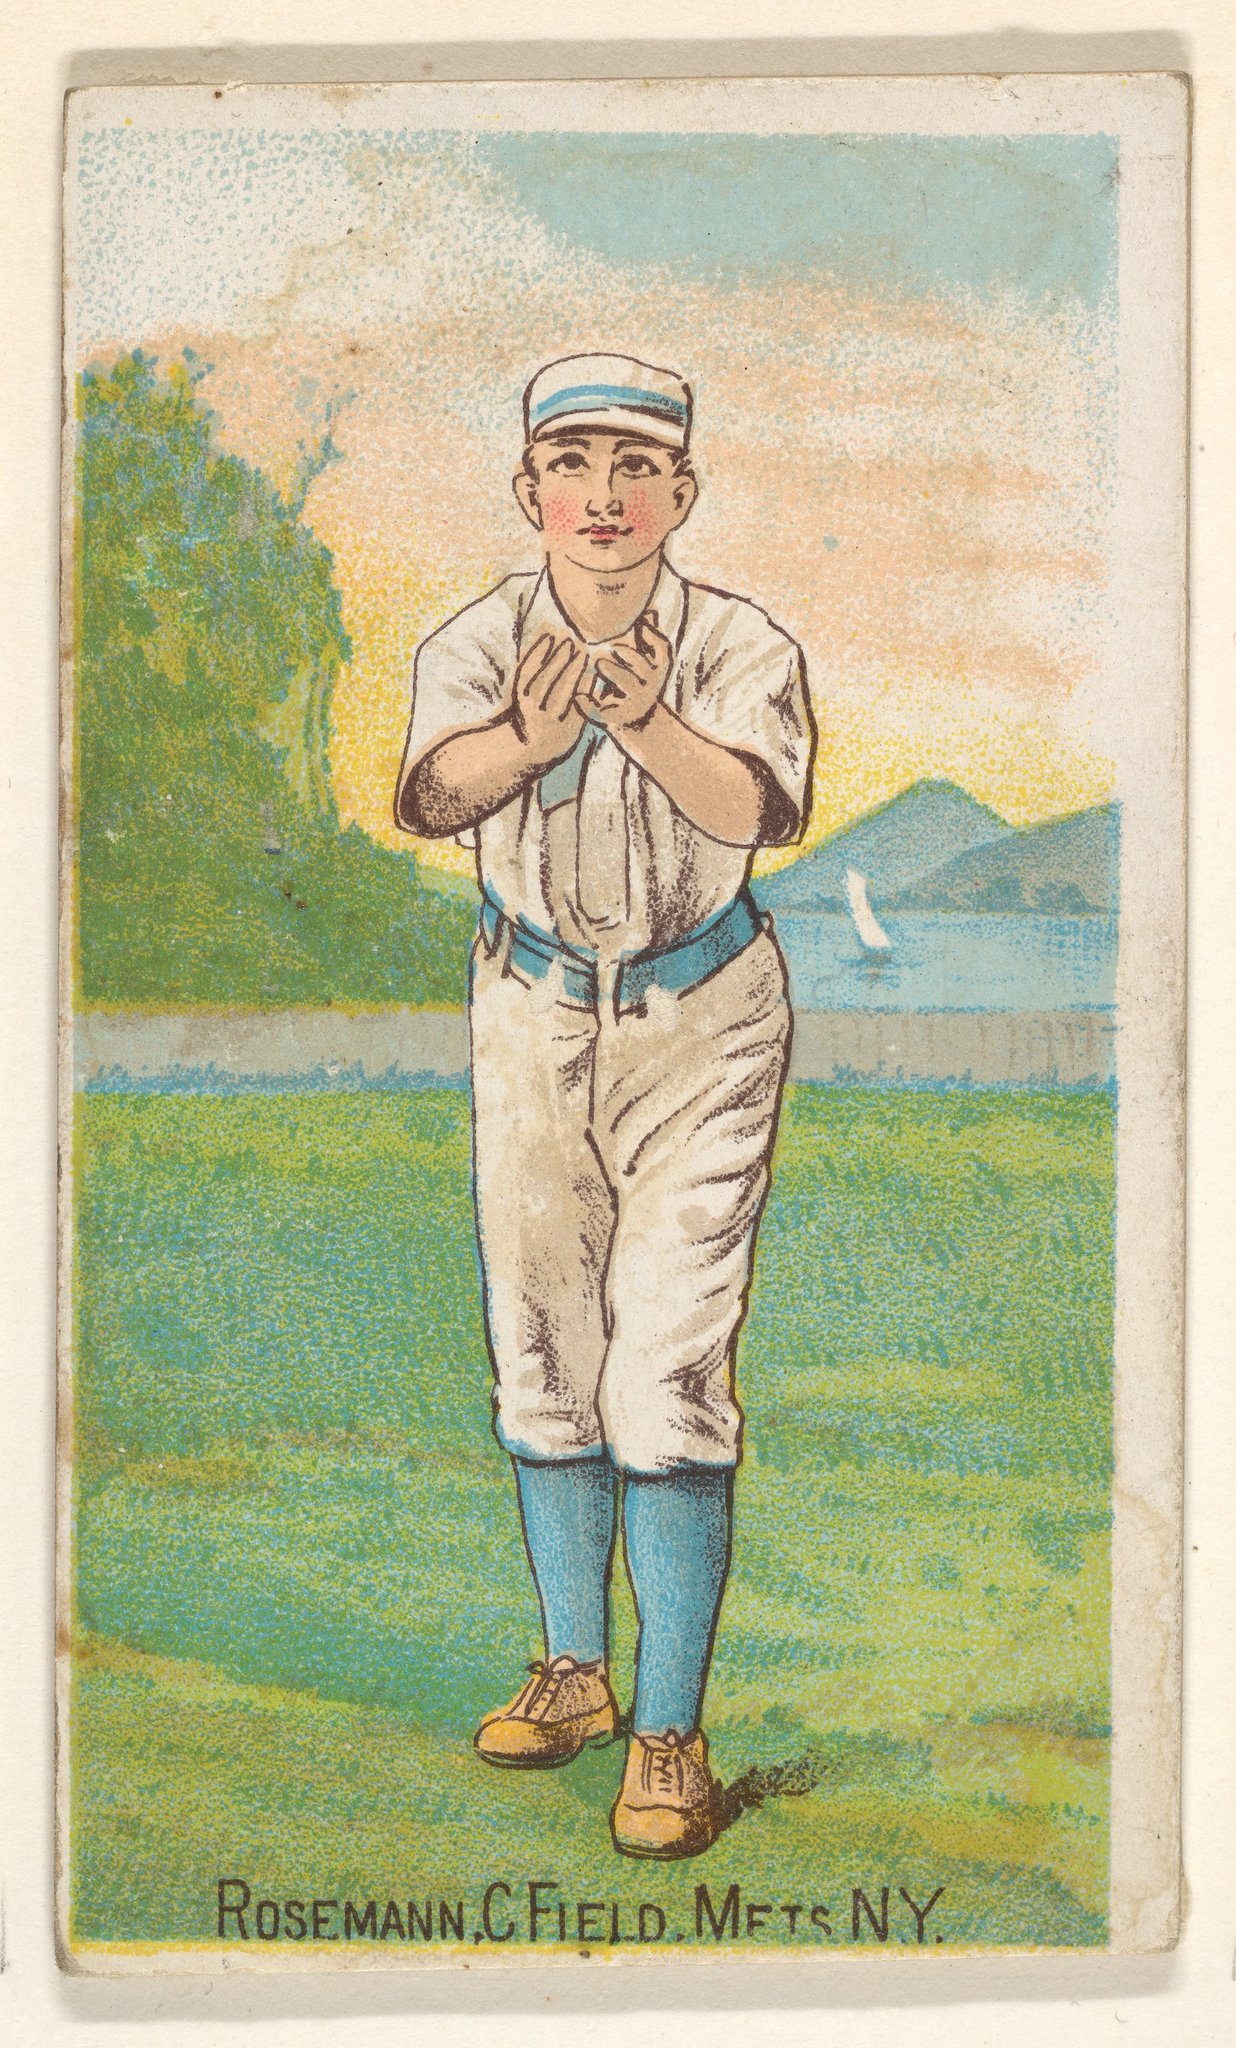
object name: baseball card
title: Rosemann, Center Field, Mets, New York, from the Gold Coin series (N284) for Gold Coin Chewing Tobacco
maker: d. buchner & co., new york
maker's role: publisher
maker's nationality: american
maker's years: 1850-1900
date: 1887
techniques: color lithograph, drawing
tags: men,baseball,athletes